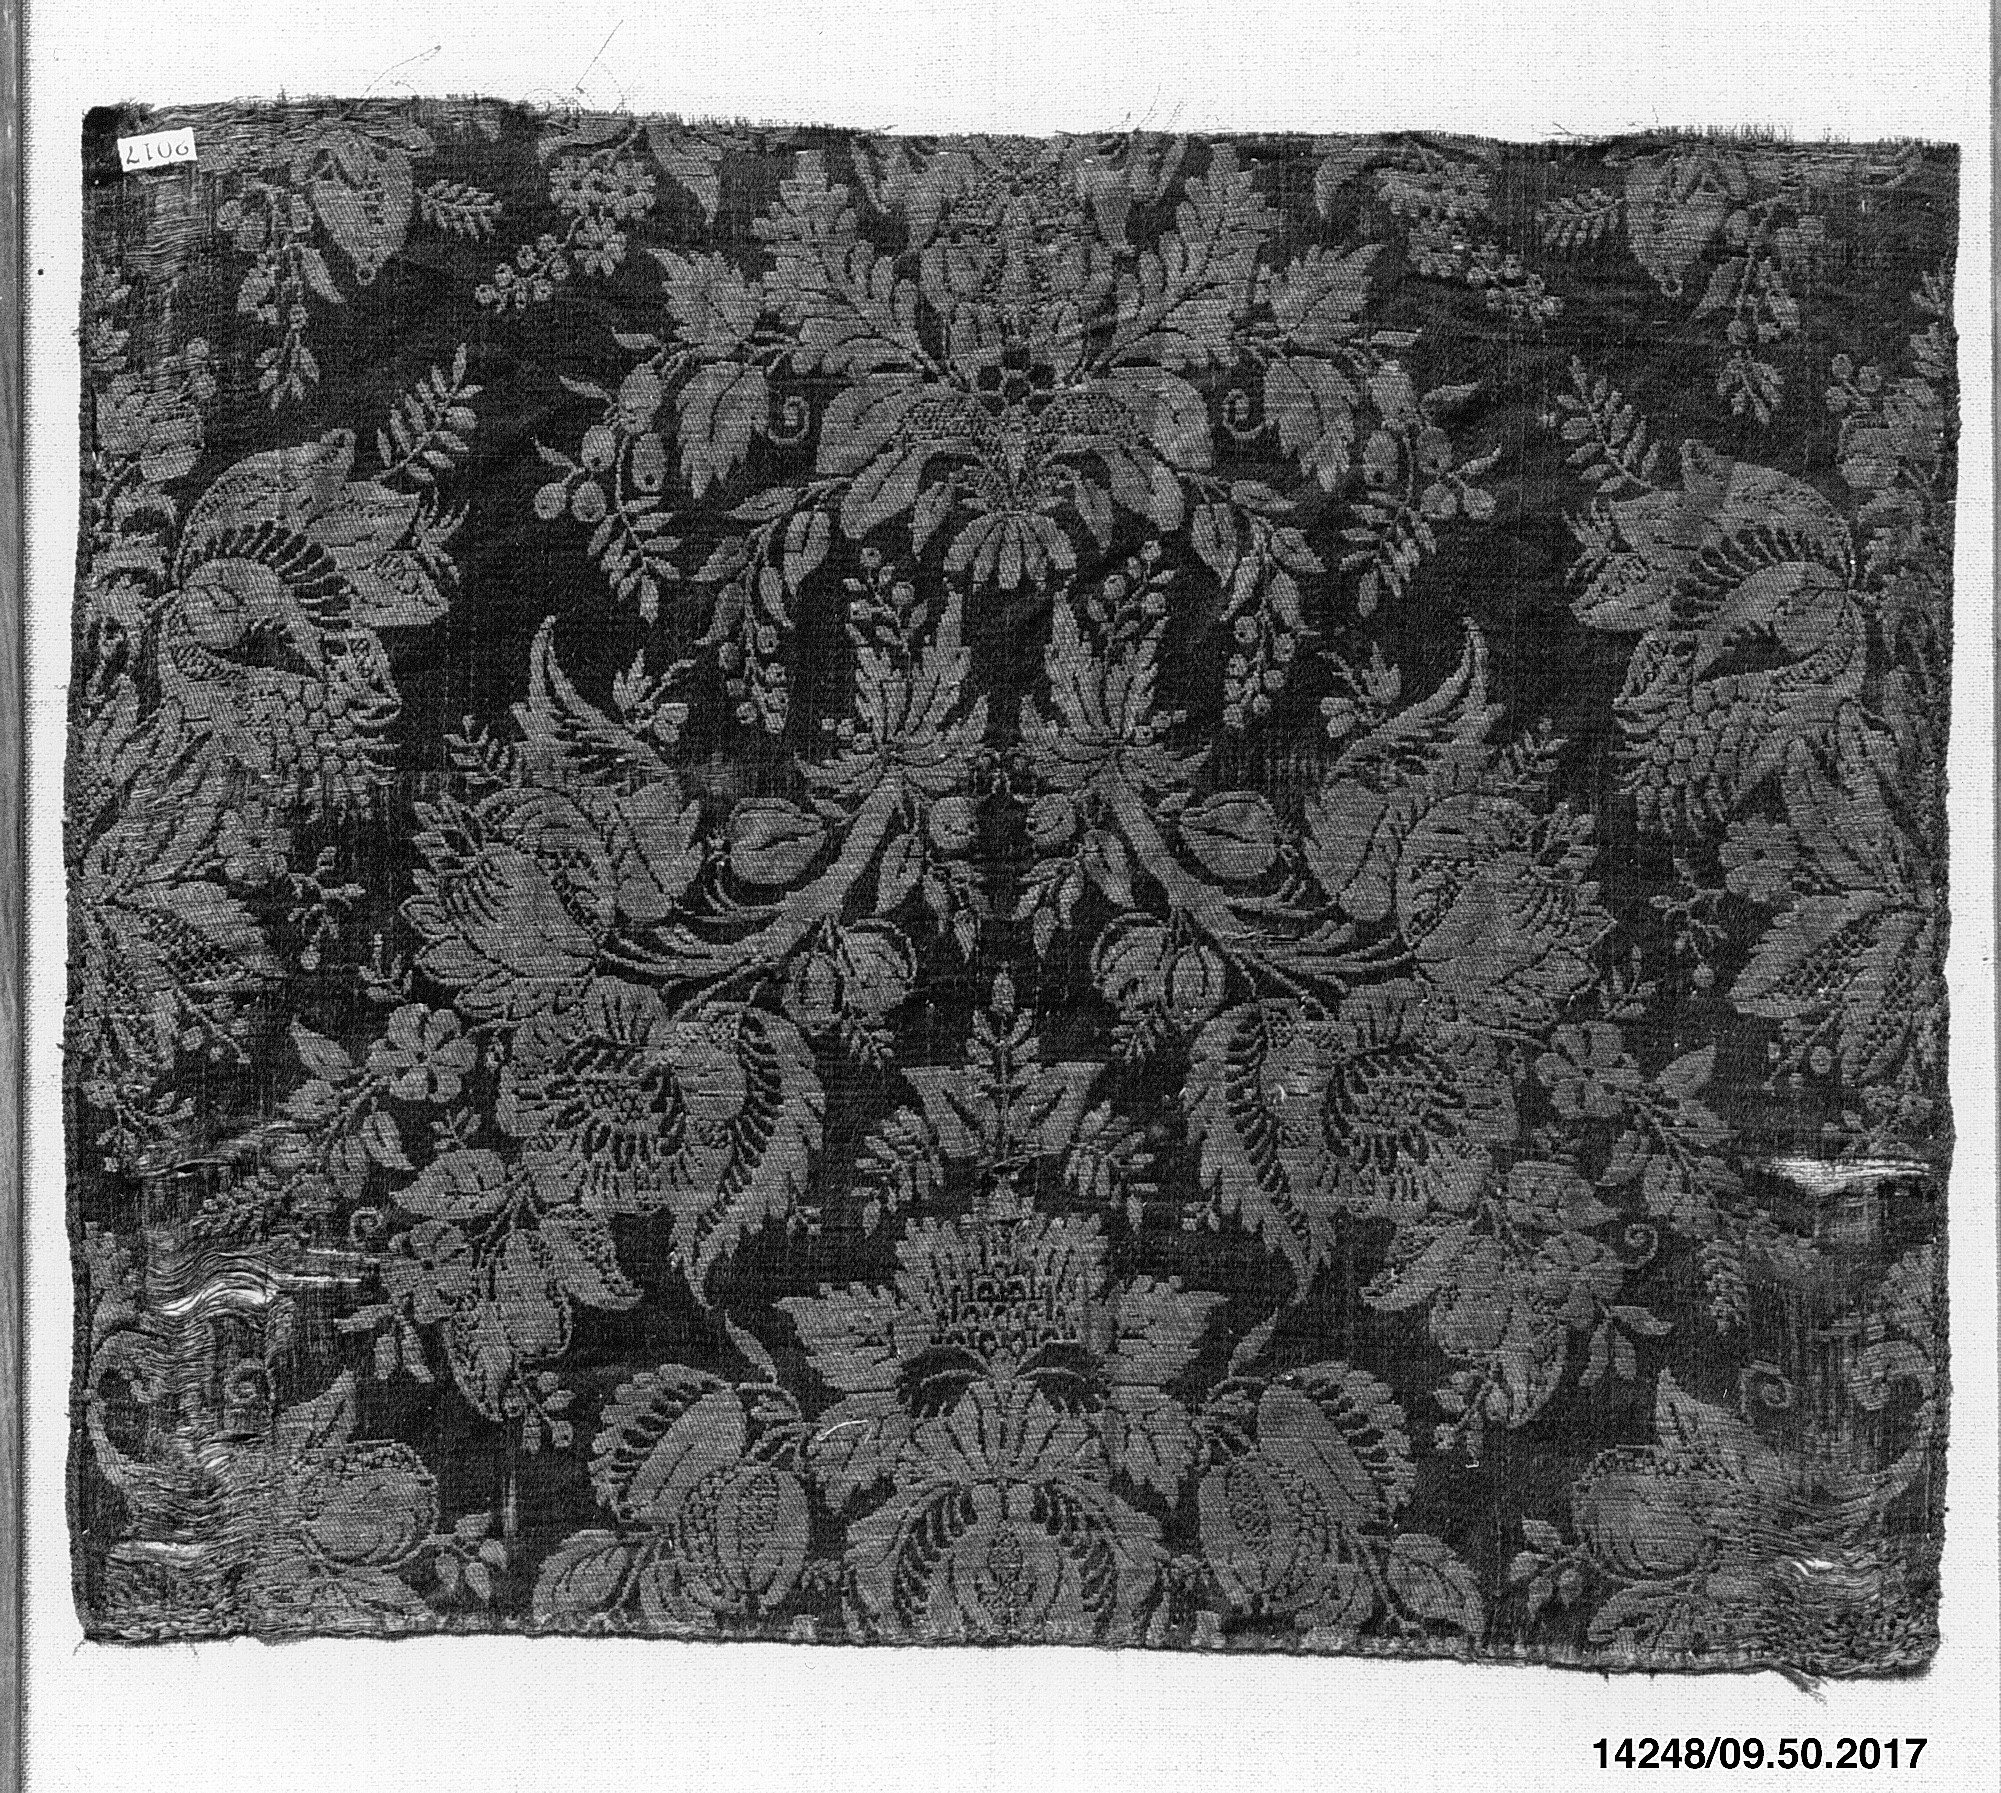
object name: piece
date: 1730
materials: linen, silk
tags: flowers,leaves